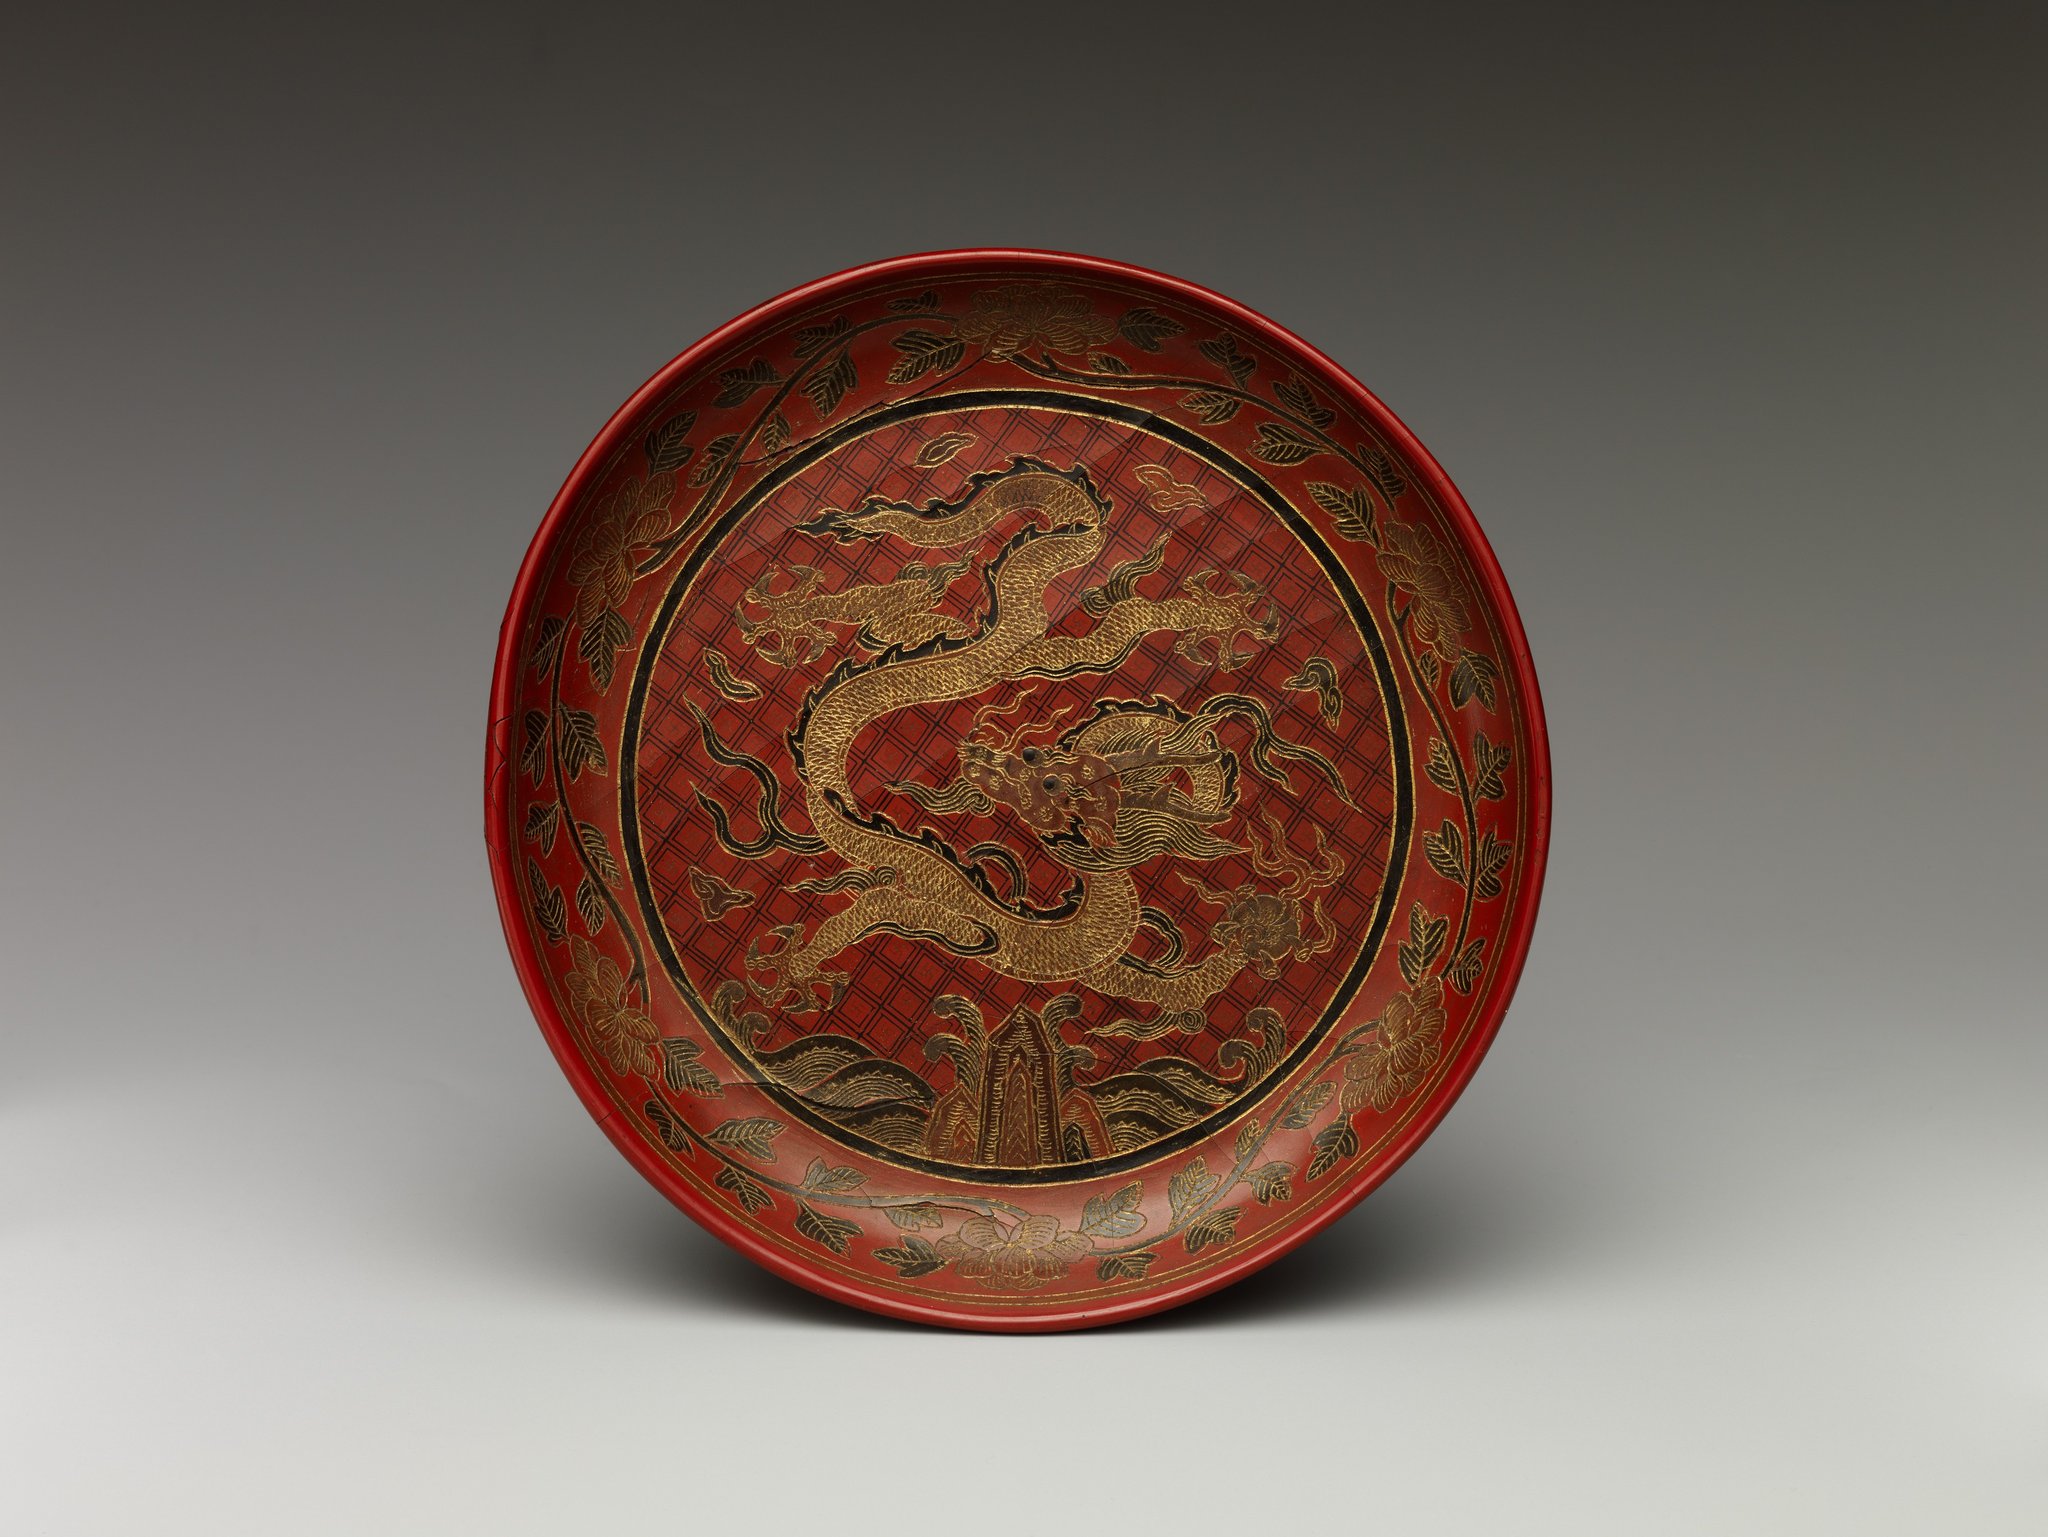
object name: dish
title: Dish with dragon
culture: chinese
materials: gold, lacquer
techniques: engraving, polychrome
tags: dragons